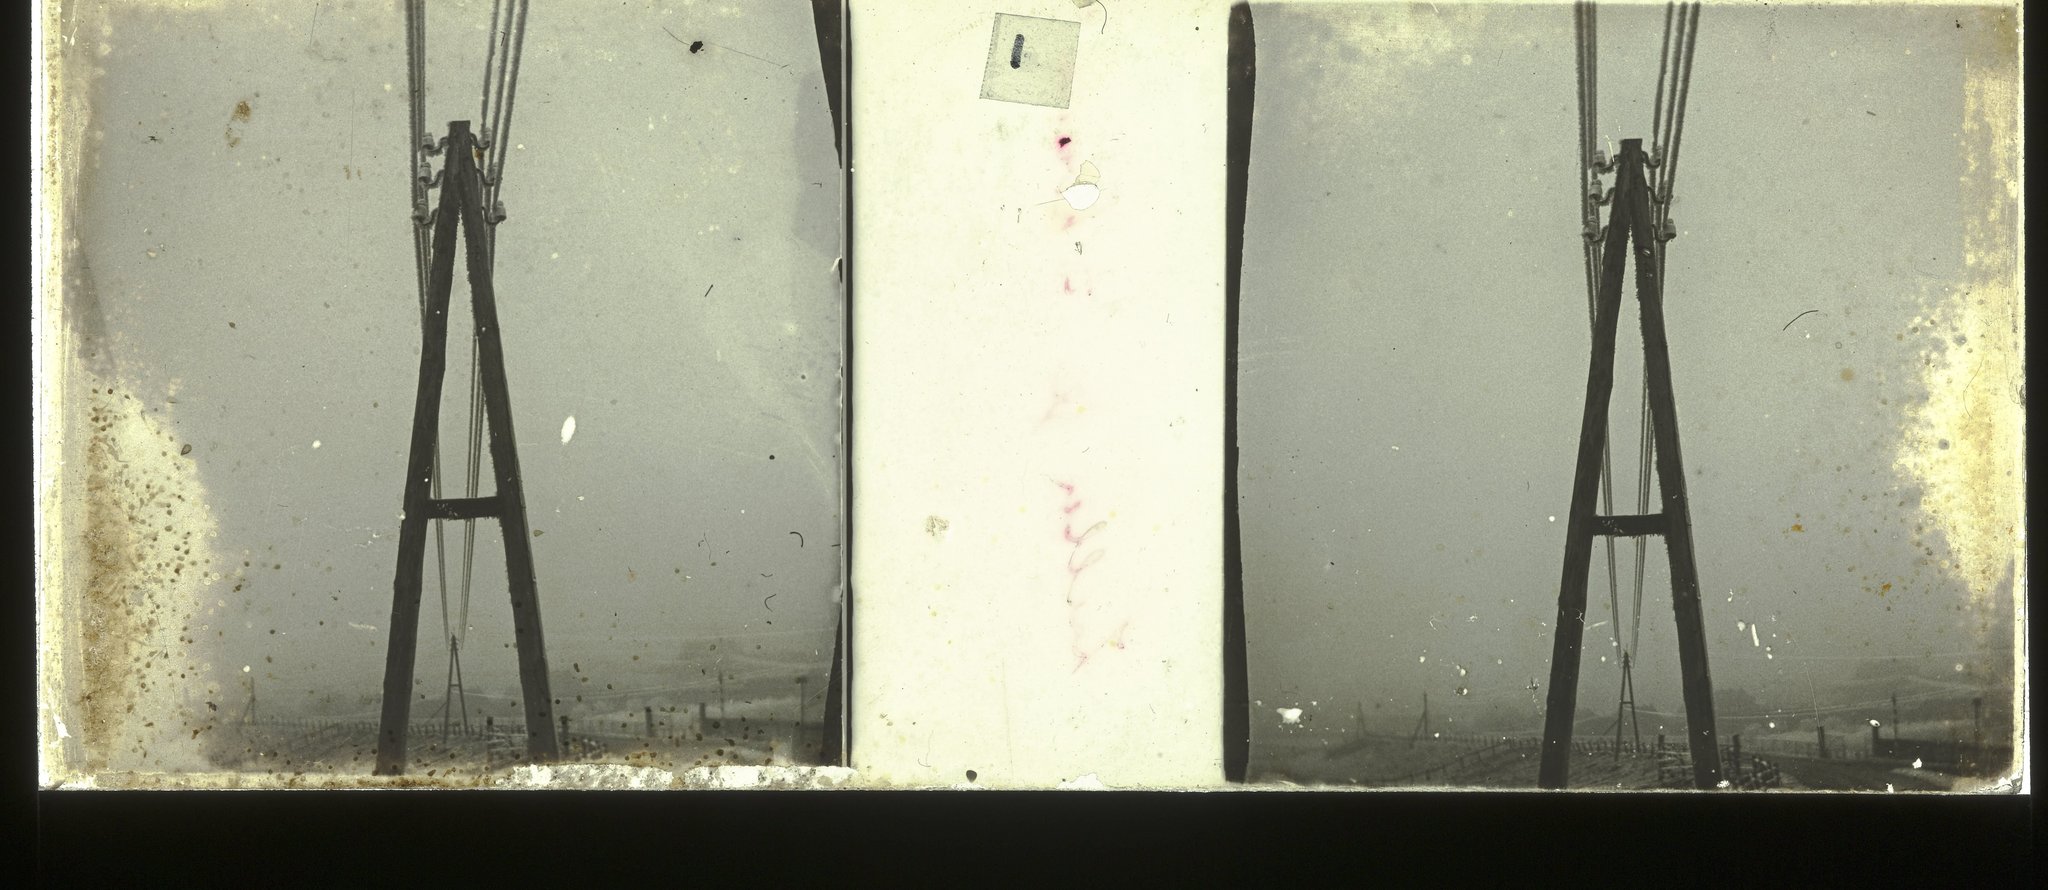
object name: stereograph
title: Elektriciteitsmast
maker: theodoor brouwers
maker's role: amateurfotograaf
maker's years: 1874-1932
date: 1913-1930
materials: glass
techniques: photography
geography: suriname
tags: amsterdam, theodoor brouwers, suriname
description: In de periode 1911-1932 woonde op plantage Accaribo in Suriname de familie Brouwers van wie de foto's afkomstig zijn. Rond 1910 vond Theodoor Brouwers werk op plantage Accaribo. In 1929 werd hij eigenaar van de plantage. Op Accaribo werden in zijn tijd bananen geproduceerd en wat koffie.